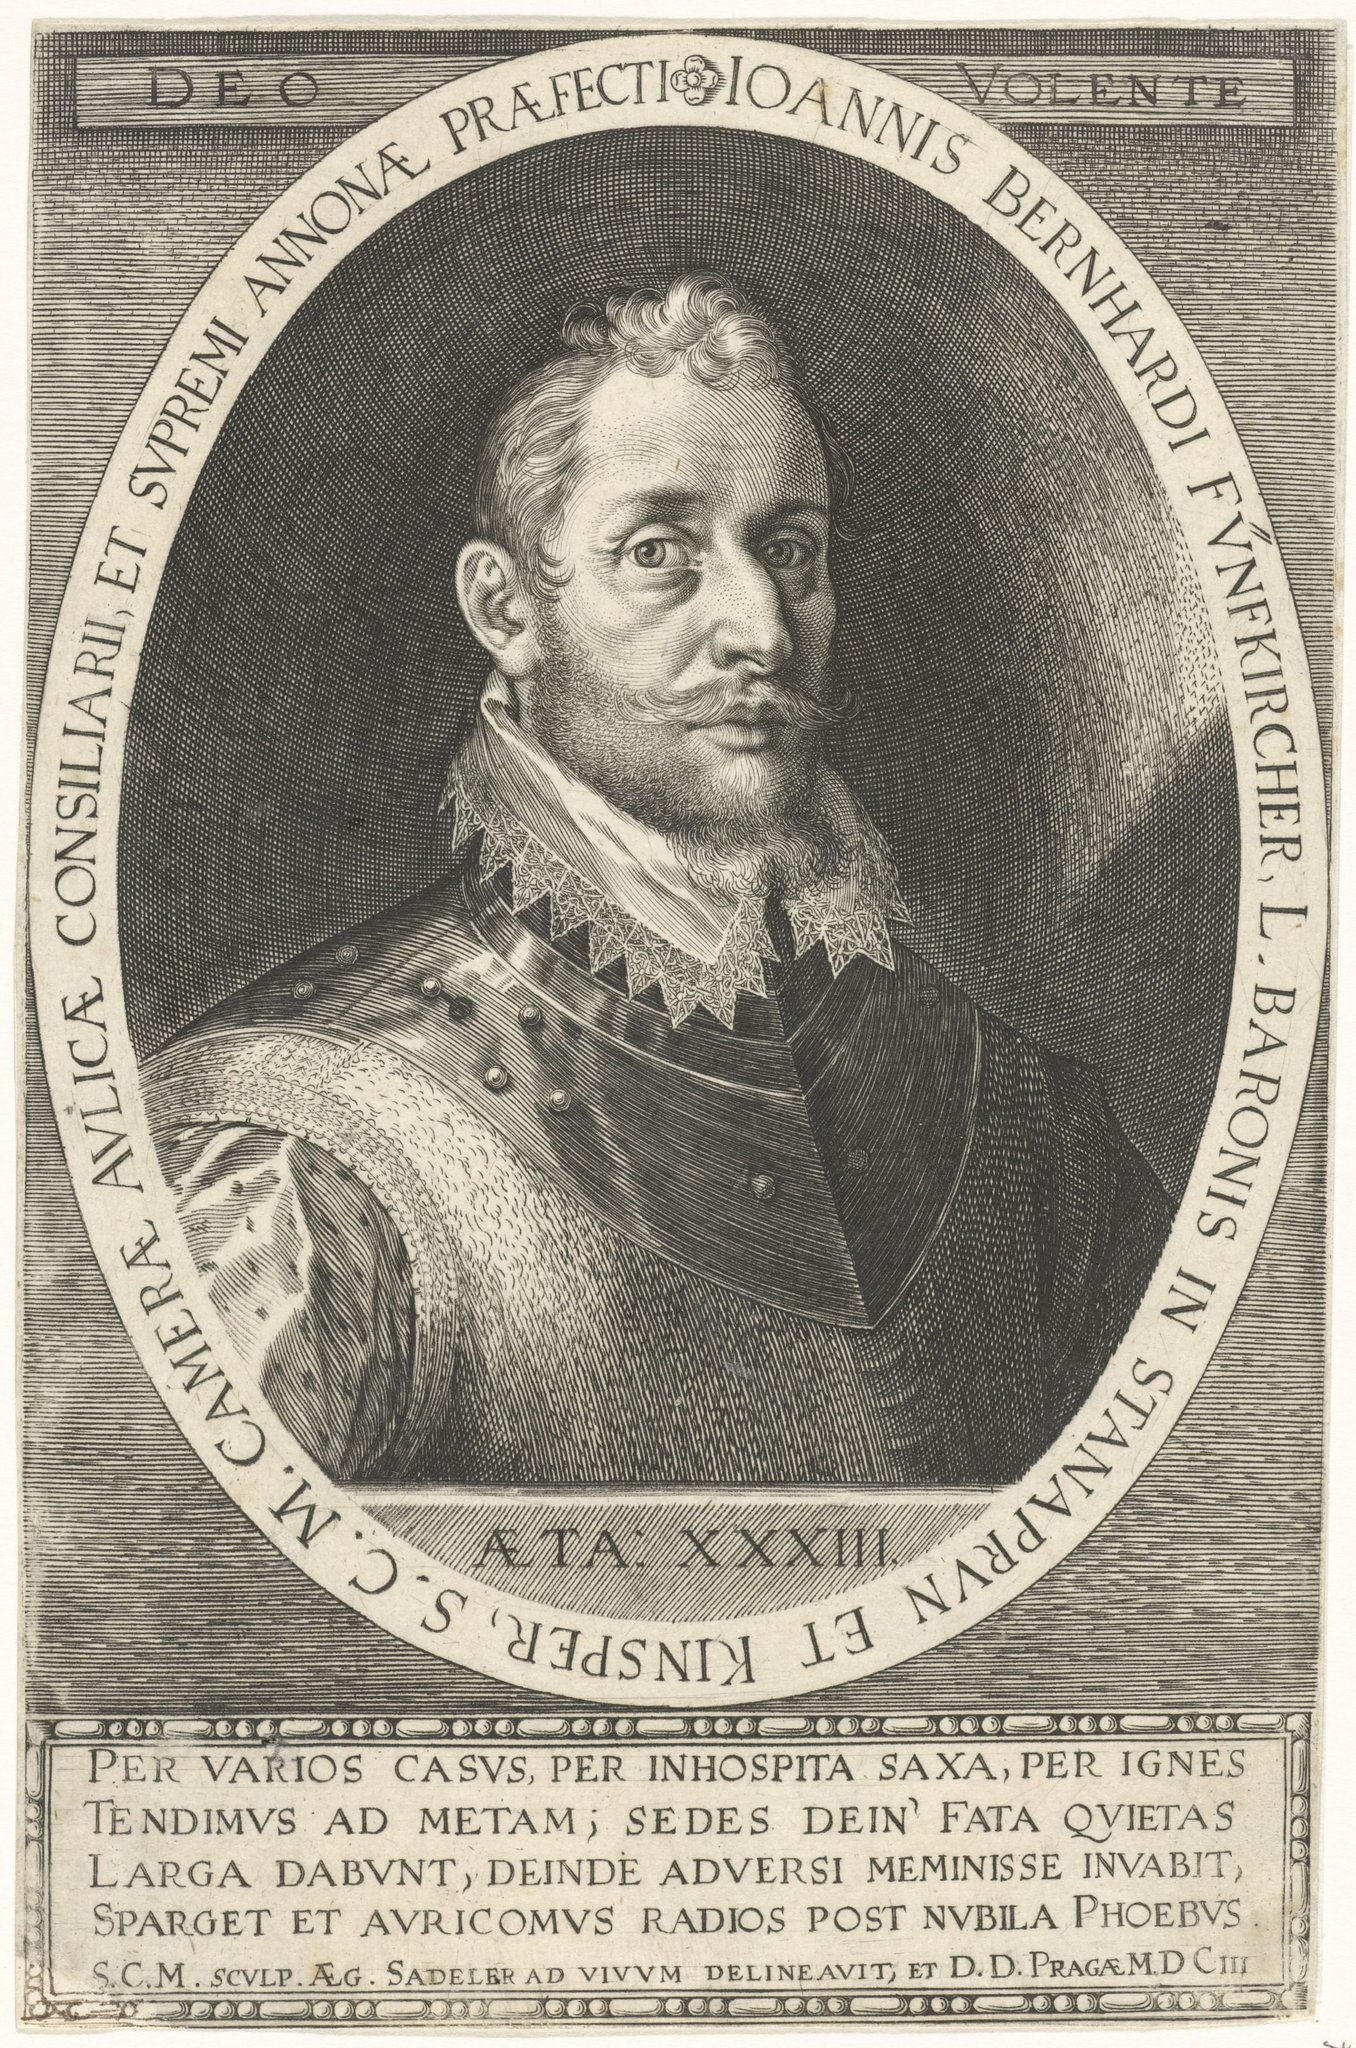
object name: print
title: Portret van Johann Bernhard von Fünfkirchen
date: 1603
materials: paper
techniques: engraving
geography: prague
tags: johann bernhard von fünfkirchen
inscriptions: collector's mark: Lugt 240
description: Johann Bernhard von Fünfkirchen was een Protestantse vrijheer. Portret op 33-jarige leeftijd. De prent heeft een Latijns onderschrift.